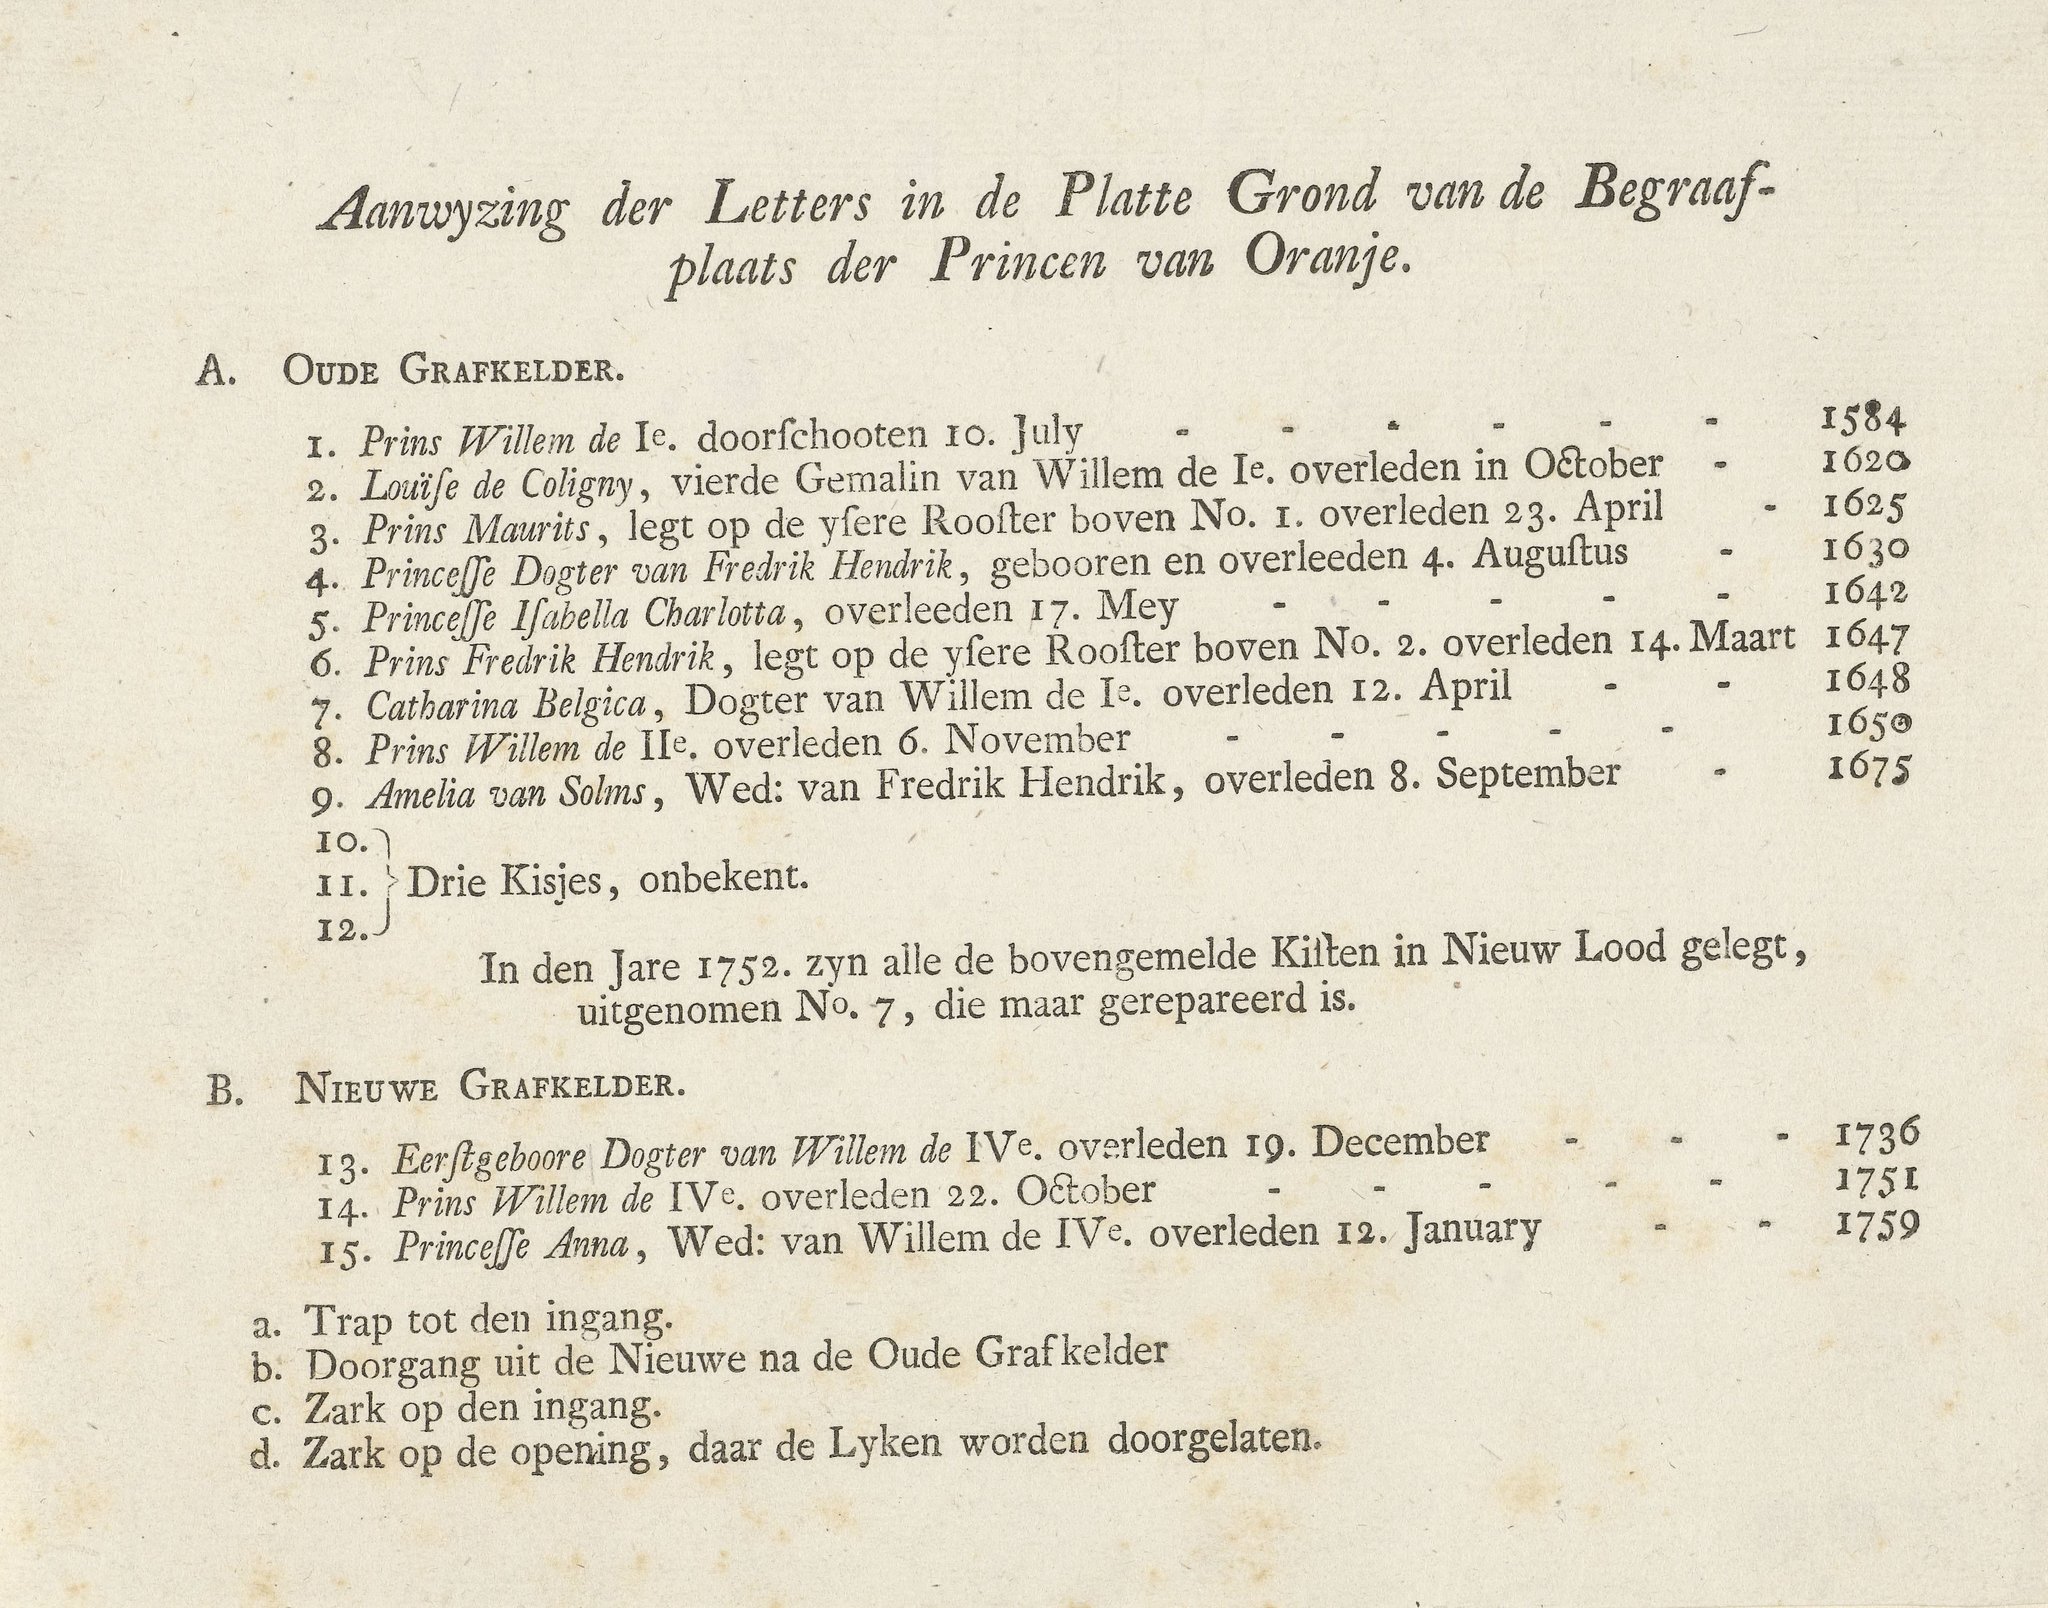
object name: text sheet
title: Legenda bij de plattegrond van de grafkelder van Oranje Nassau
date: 1743-1790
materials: paper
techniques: letterpress printing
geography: delft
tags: nieuwe kerk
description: Verklaring van de nummers en letters in de plattegrond van de grafkelder van Oranje Nassau.